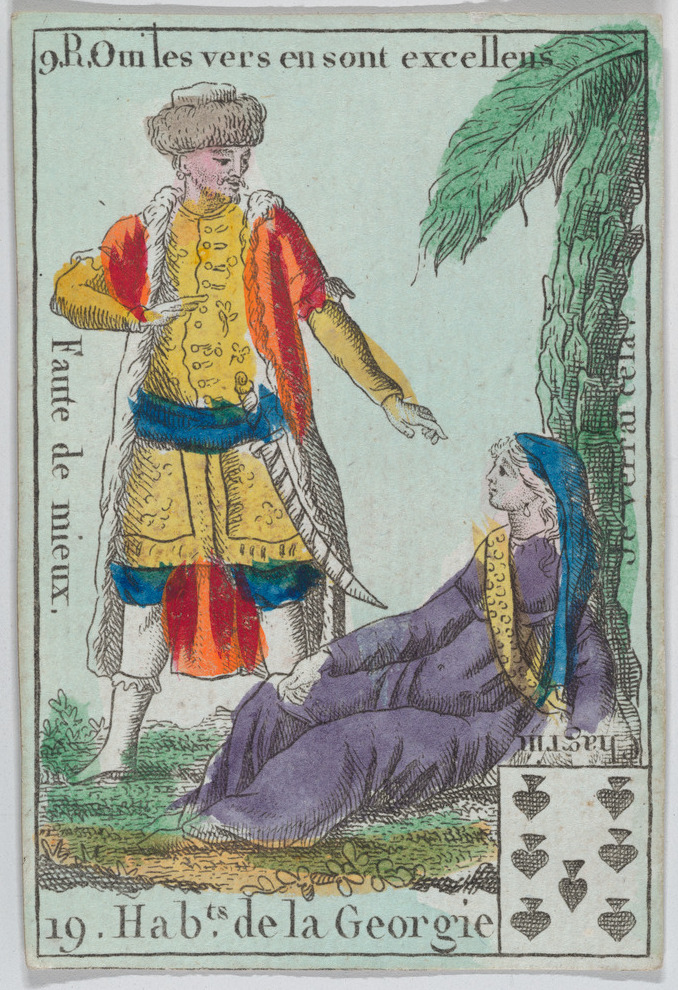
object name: print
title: Hab.ts de la Georgie from playing cards "Jeu d'Or"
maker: anonymous, french, 18th century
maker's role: artist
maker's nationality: french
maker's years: 1700-1800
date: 1700-1799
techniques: etching, hand coloring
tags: men,women,playing cards